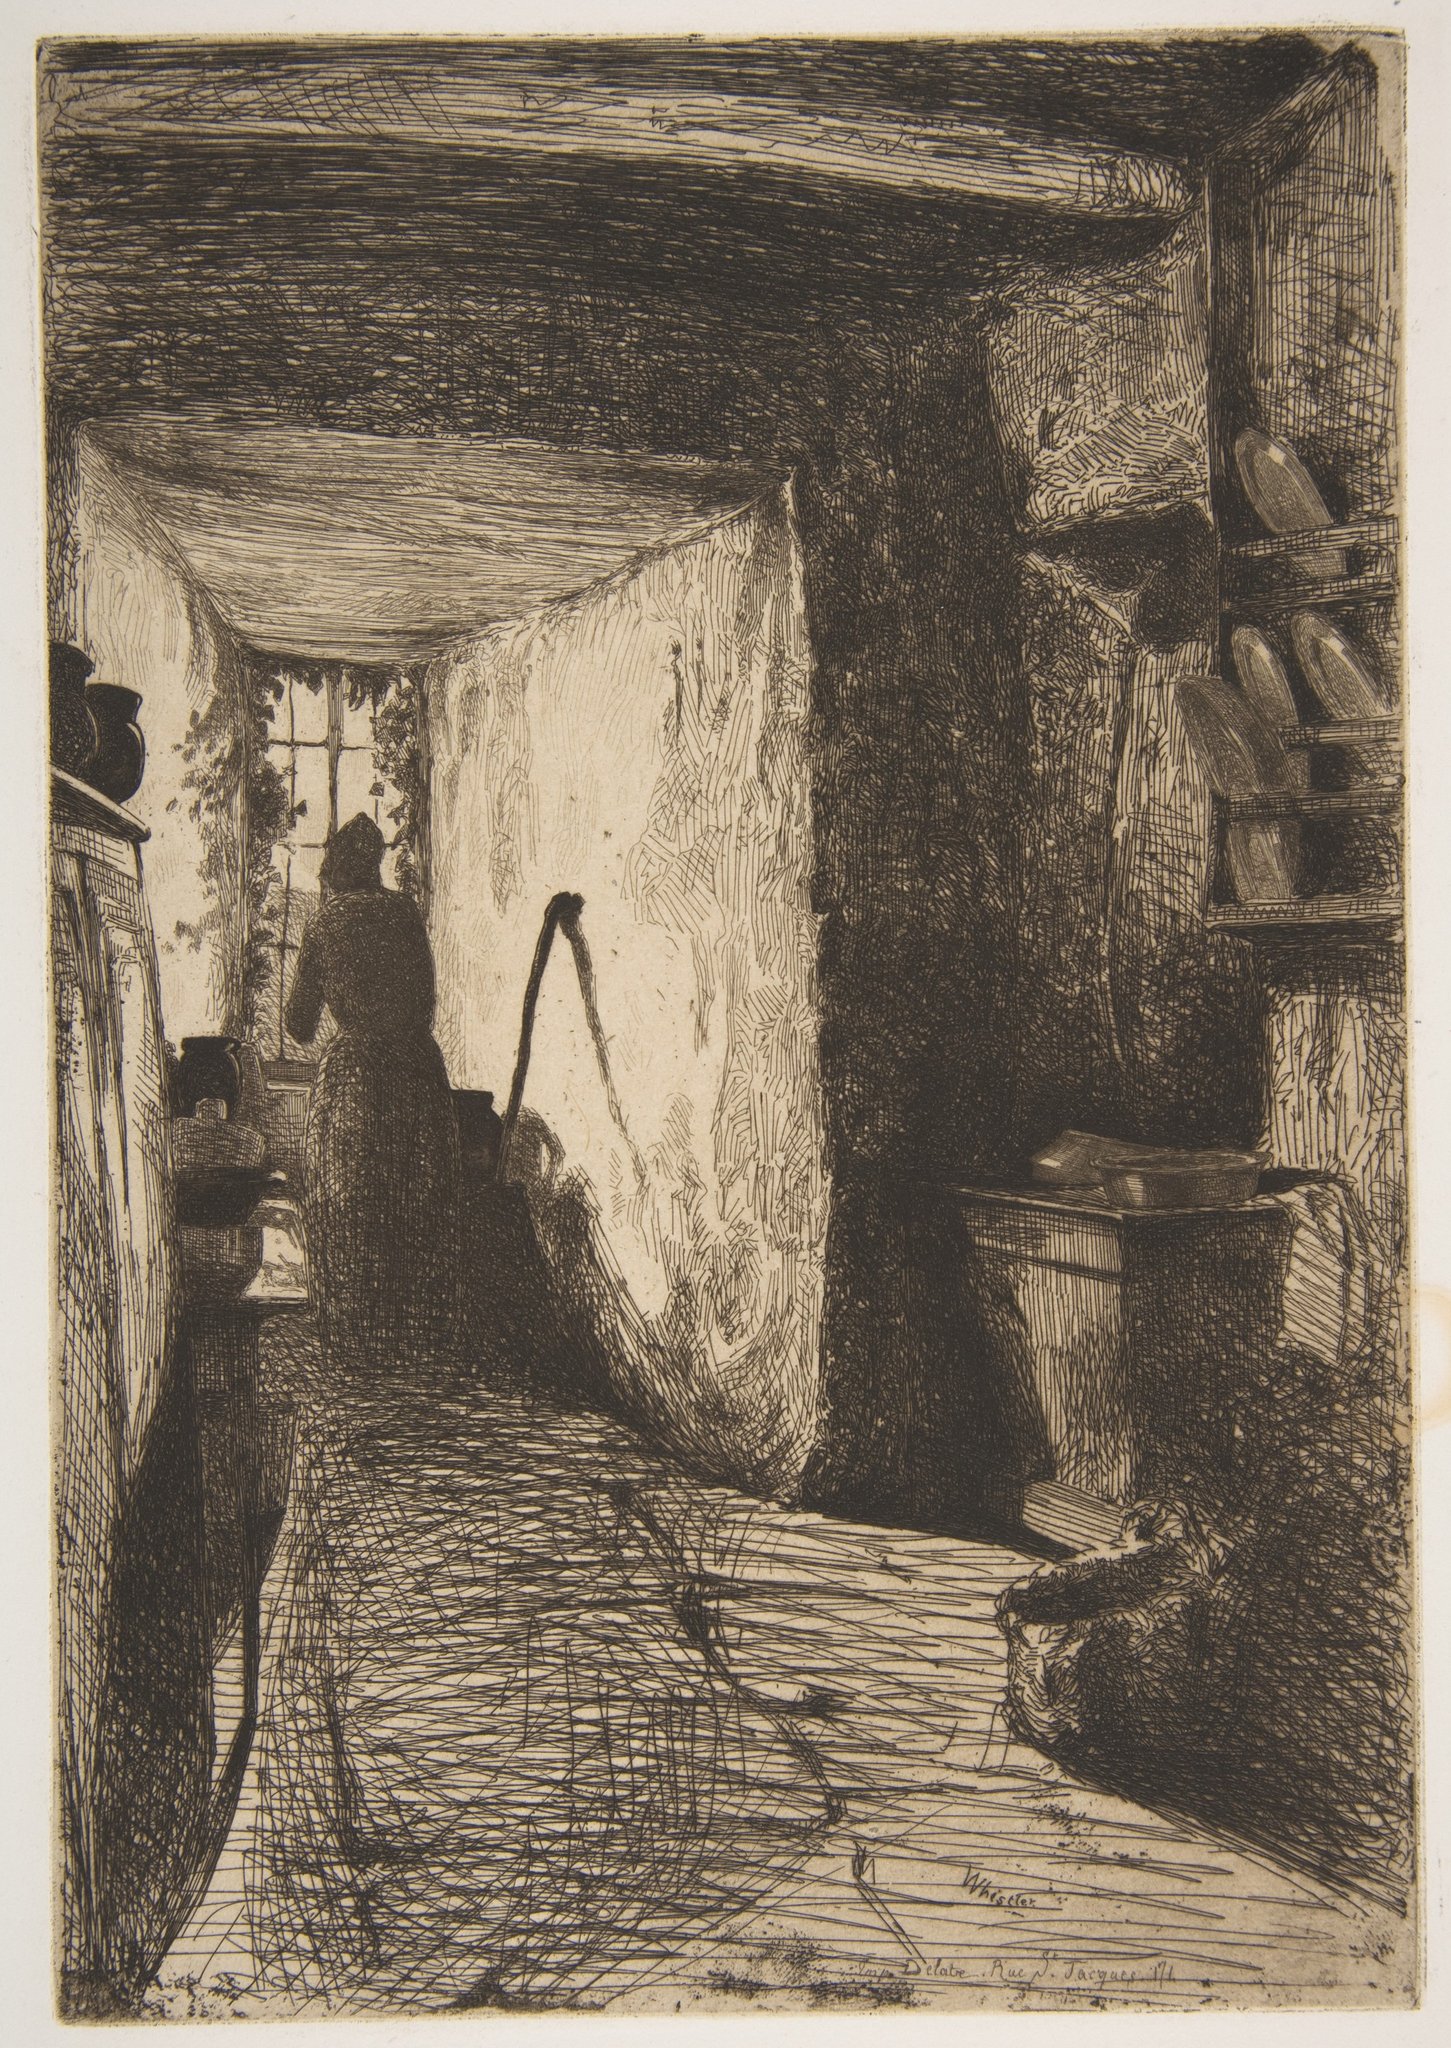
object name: print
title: The Kitchen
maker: james mcneill whistler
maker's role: artist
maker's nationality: american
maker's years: 1834-1903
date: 1858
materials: chine, ink, paper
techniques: printmaking, etching, printing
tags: interiors,kitchens